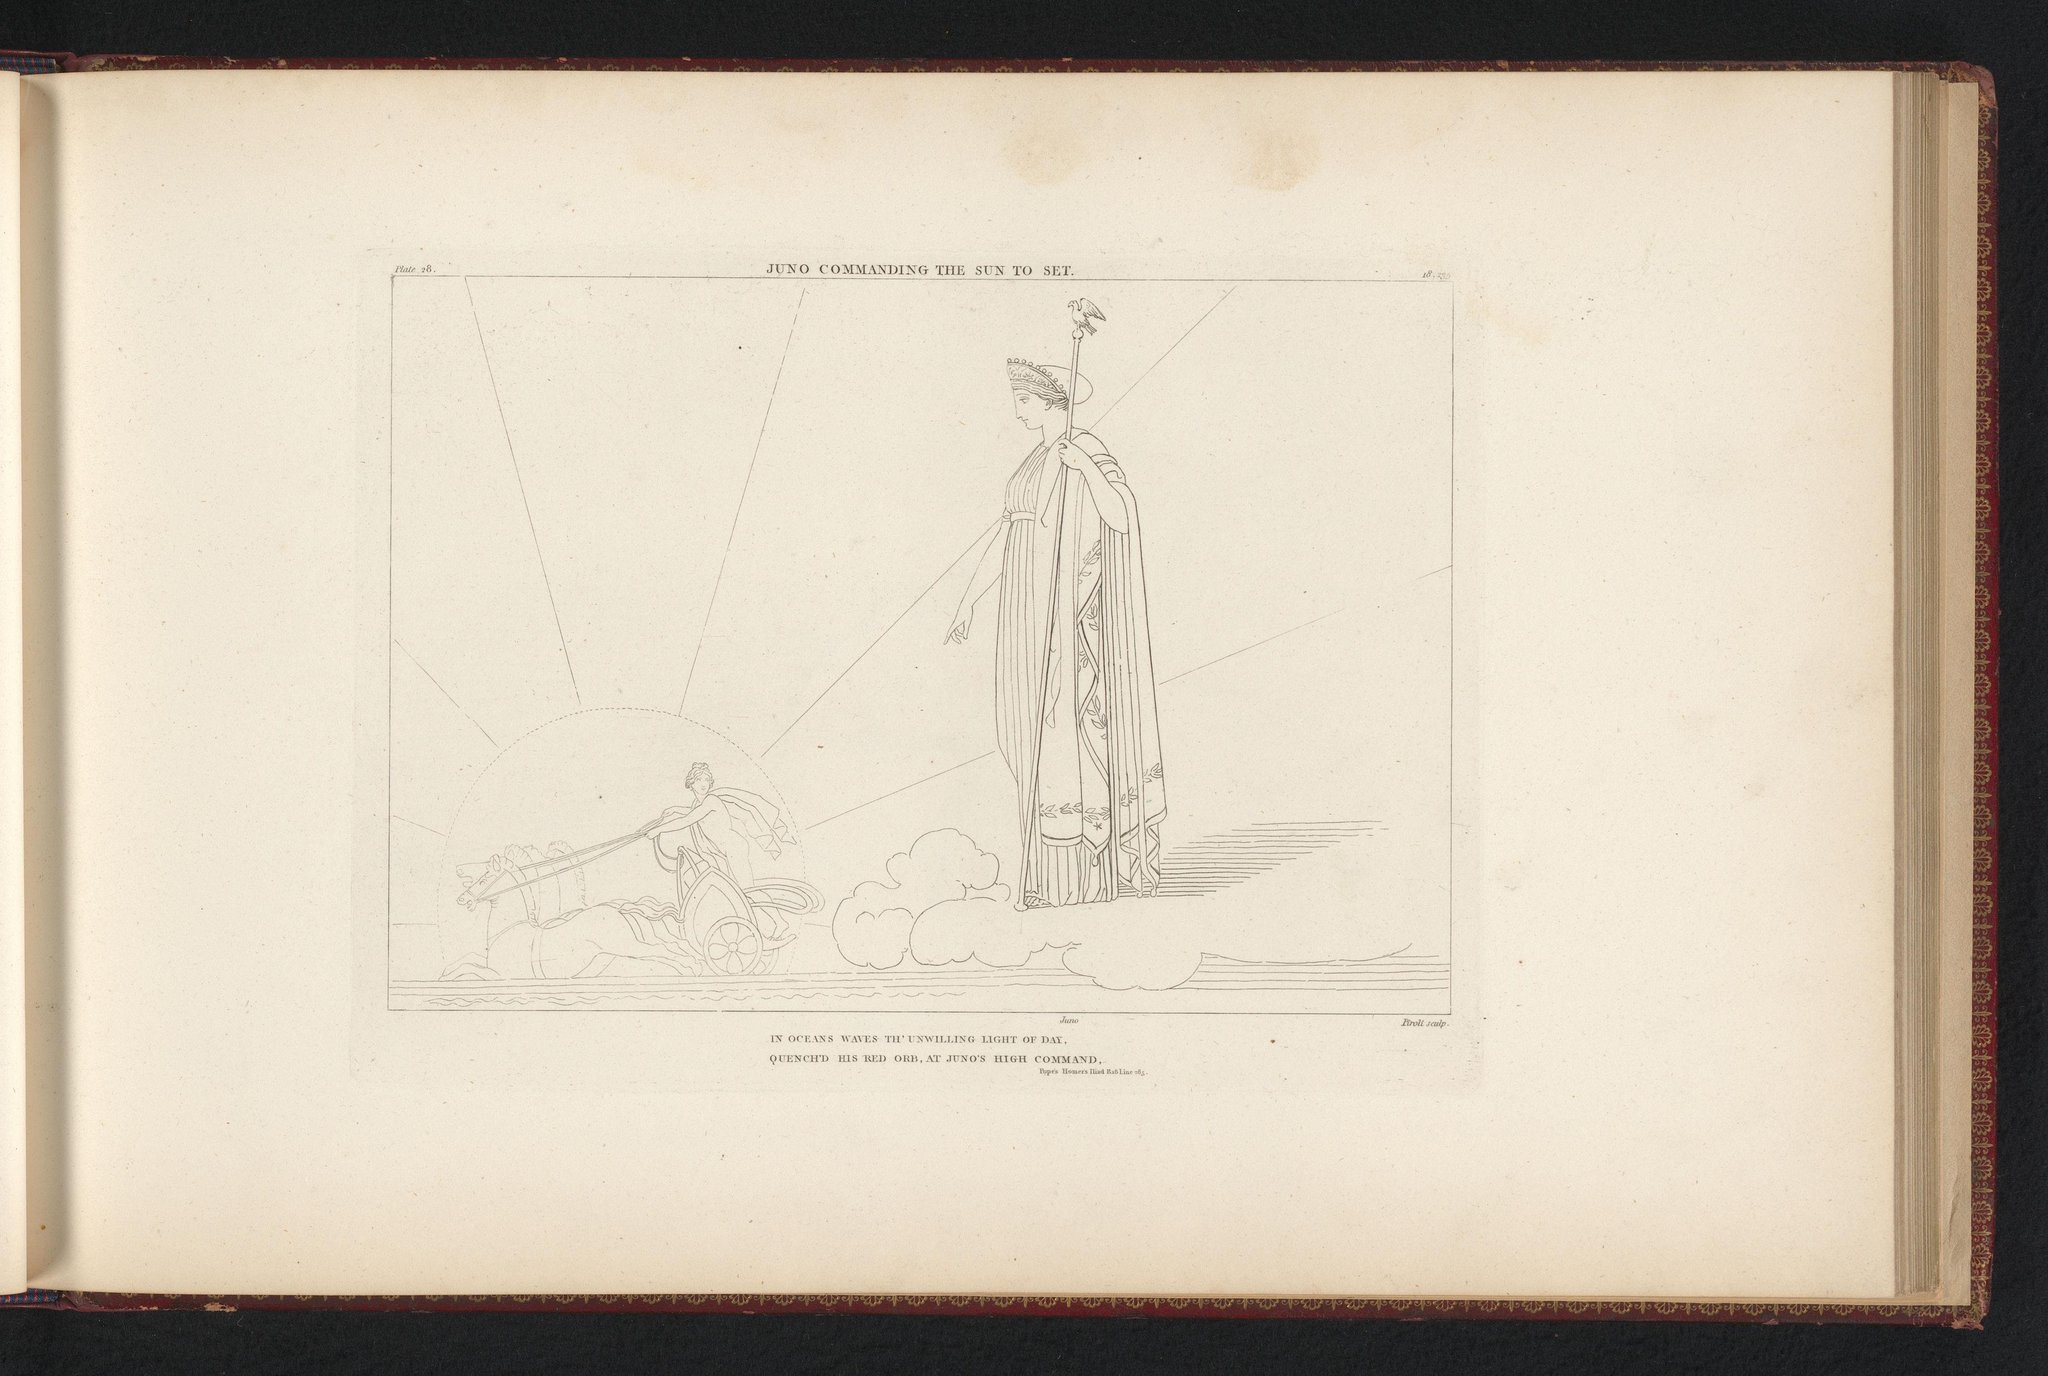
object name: album leaf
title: Ilias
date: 1805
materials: paper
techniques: etching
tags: (story of) juno (hera), sunset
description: Prent maakt onderdeel uit van een serie met 39 prenten over de Ilias, geschreven door Homerus.